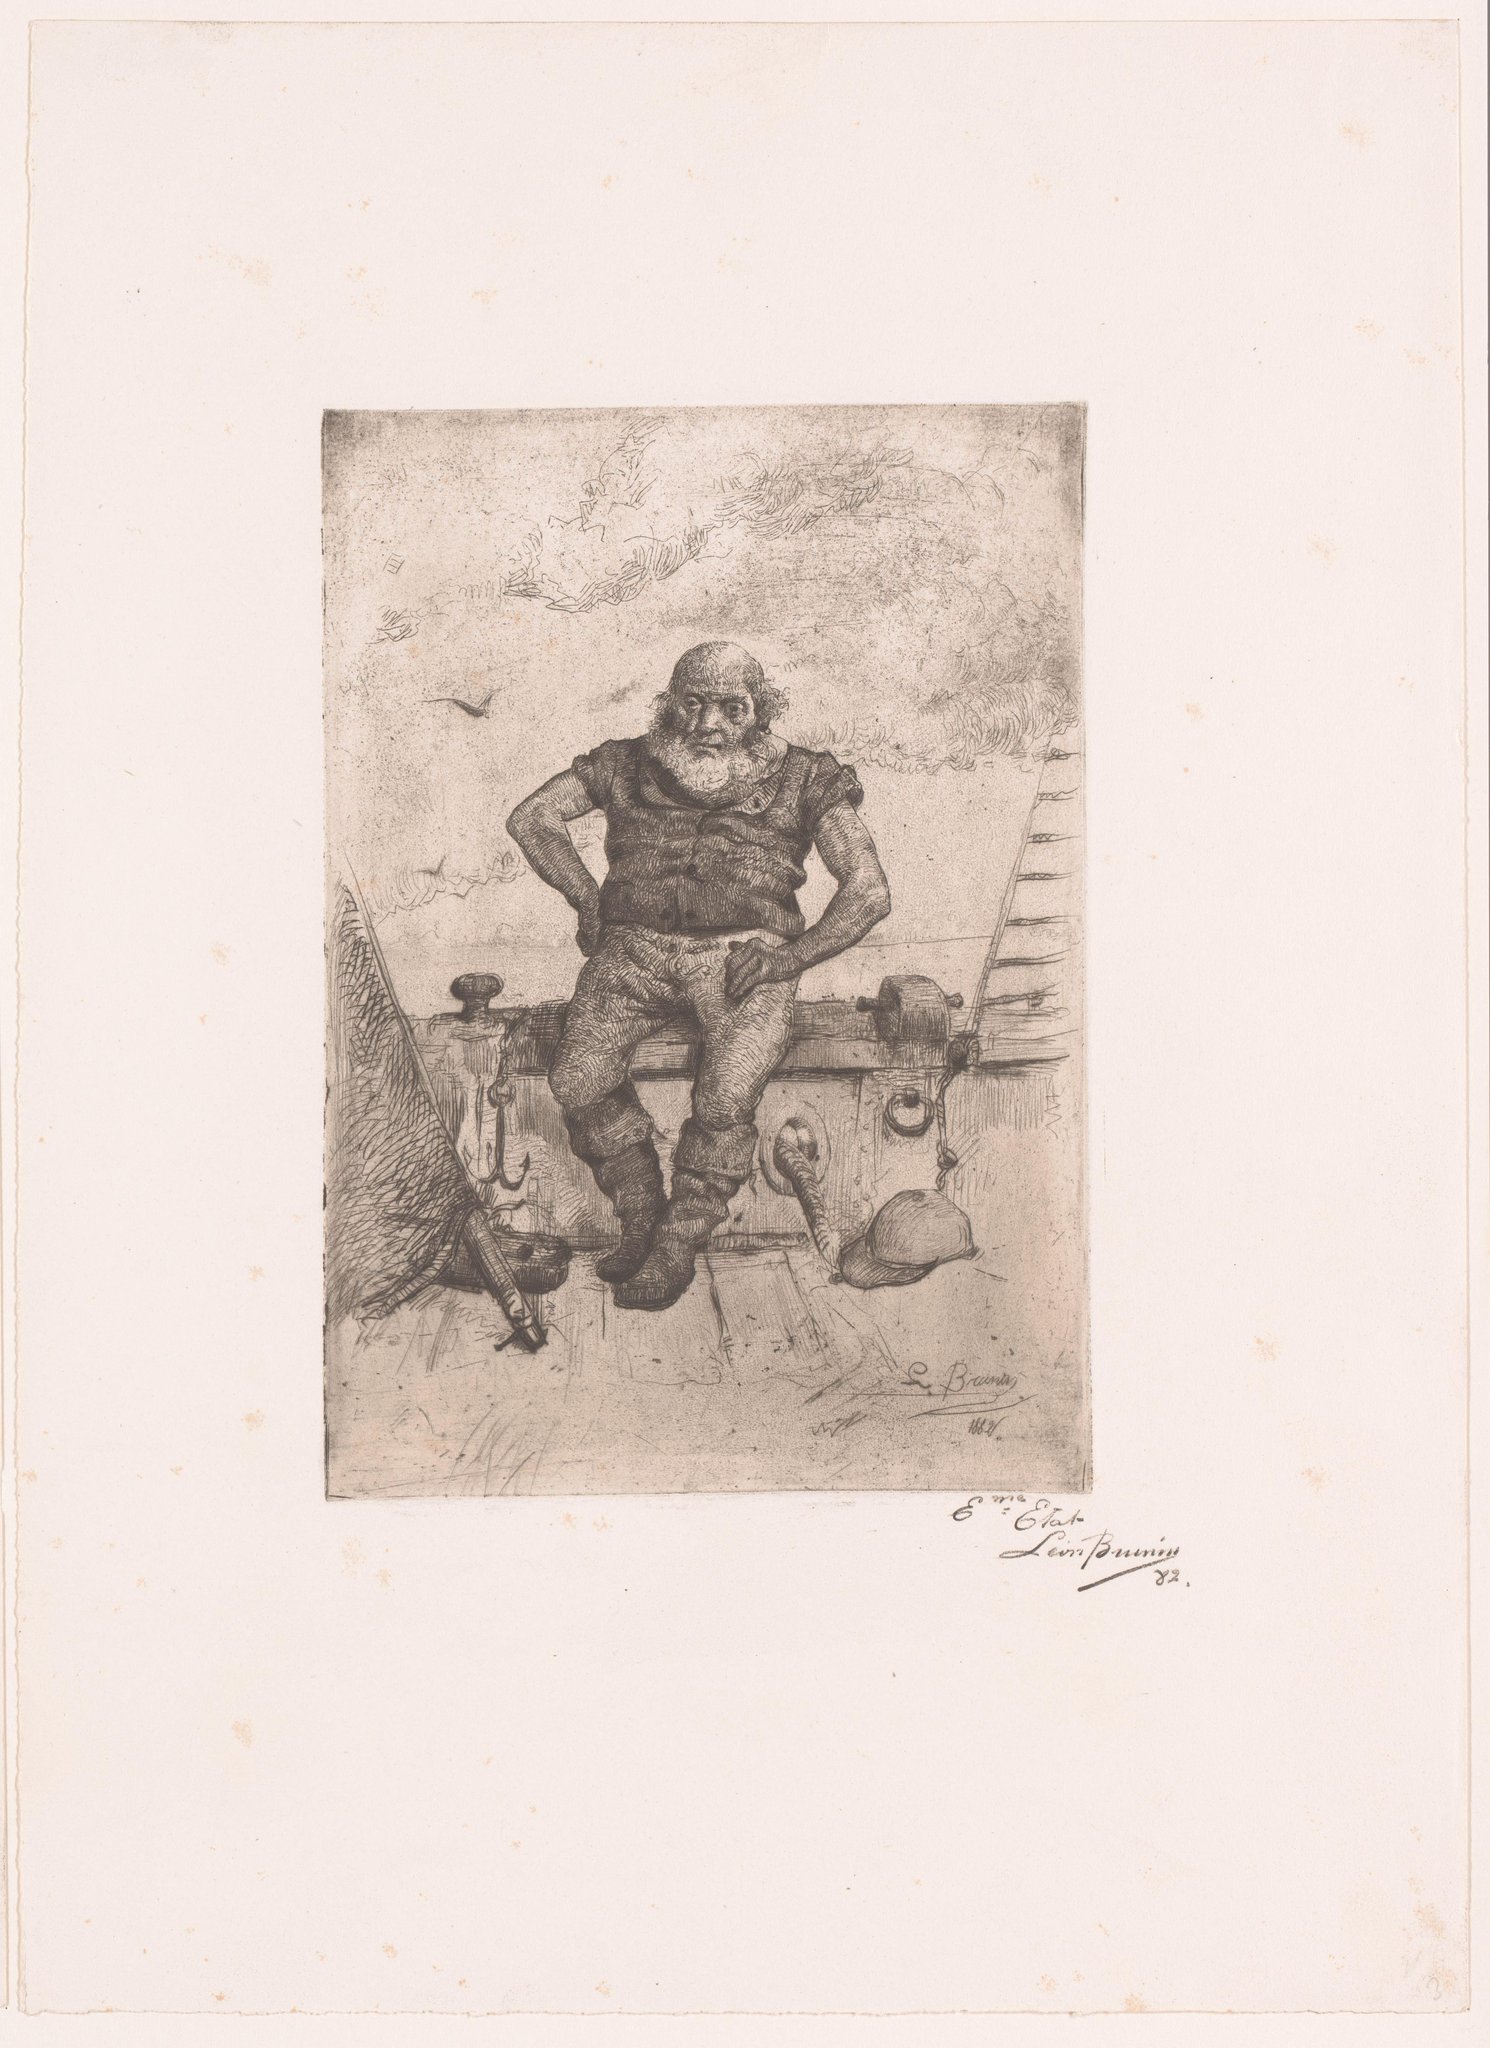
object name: print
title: Zeeman of visser aan boord van een schip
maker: léon brunin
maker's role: print maker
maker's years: 1861-1949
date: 1882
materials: paper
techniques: etching, intaglio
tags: seaman: sailor, fisherman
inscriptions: annotation: ‘Eme. Etat’, collector's mark: Lugt 2228